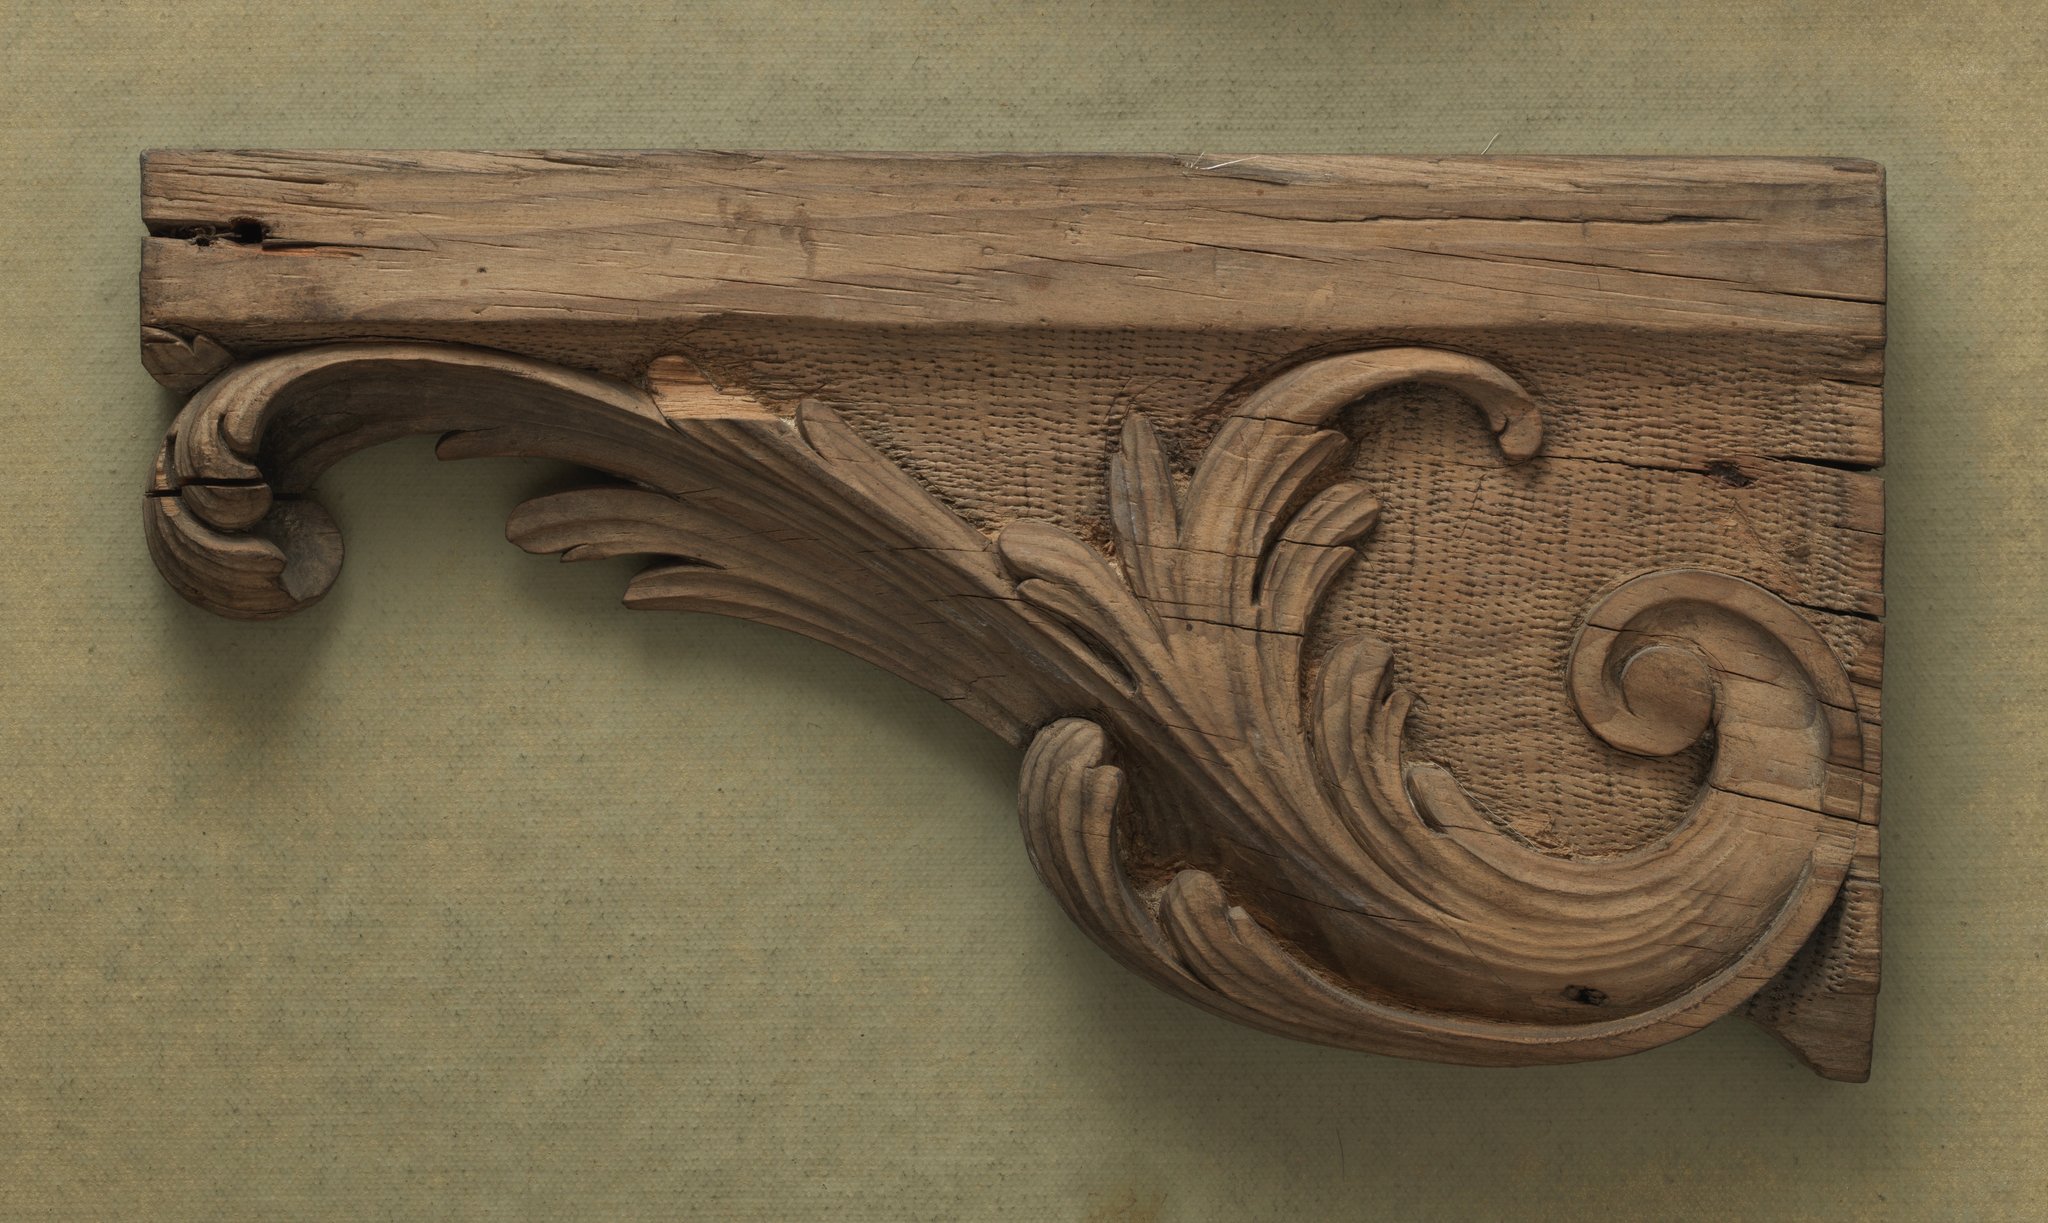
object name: bracket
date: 1701-1800